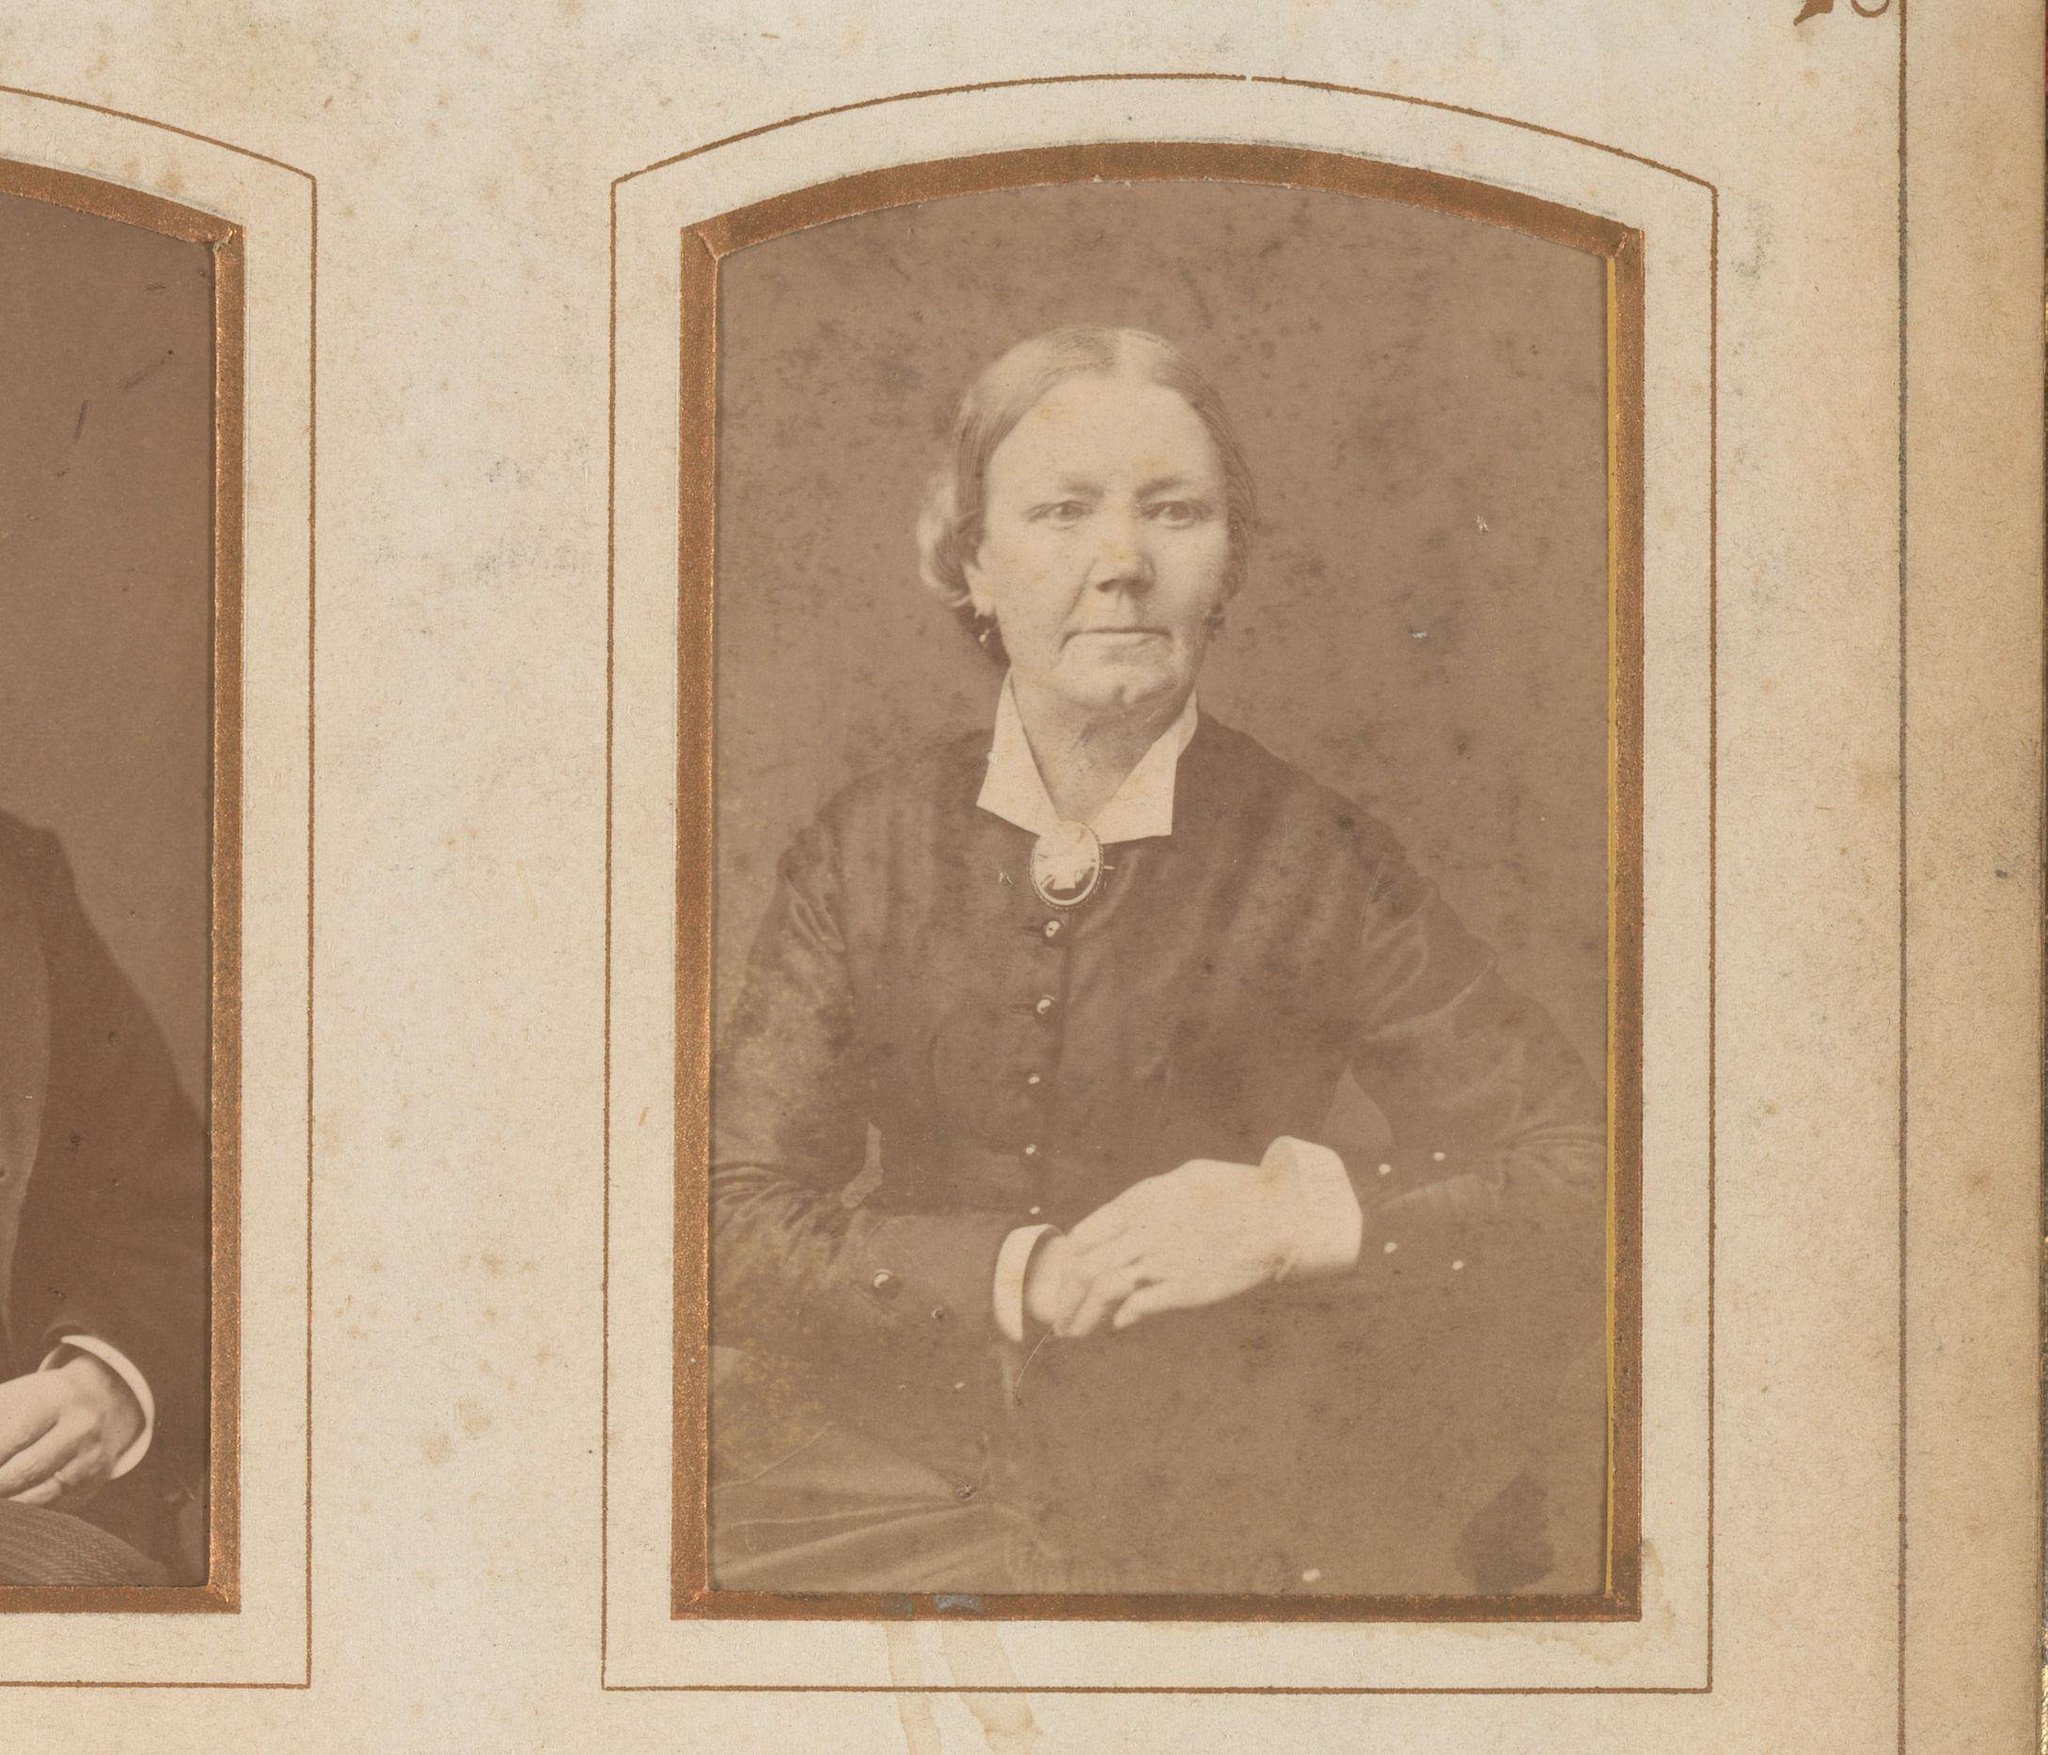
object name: carte de visite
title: Portret van een zittende vrouw met halssieraad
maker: charlotta wilhelmina edberg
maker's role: fotograaf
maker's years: 1841-1927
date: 1860-1900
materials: cardboard, photographic support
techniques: albumen print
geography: stockholm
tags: sitting figure - aa - female human figure, historical persons - bb - woman, necklace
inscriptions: inscription: ‘Fotografi/ Atelier/ C. W. Edberg/ Stockholm/ Köpmangatan 12/ ingång från granden/ Plåten förvaras för efterbeställning.’